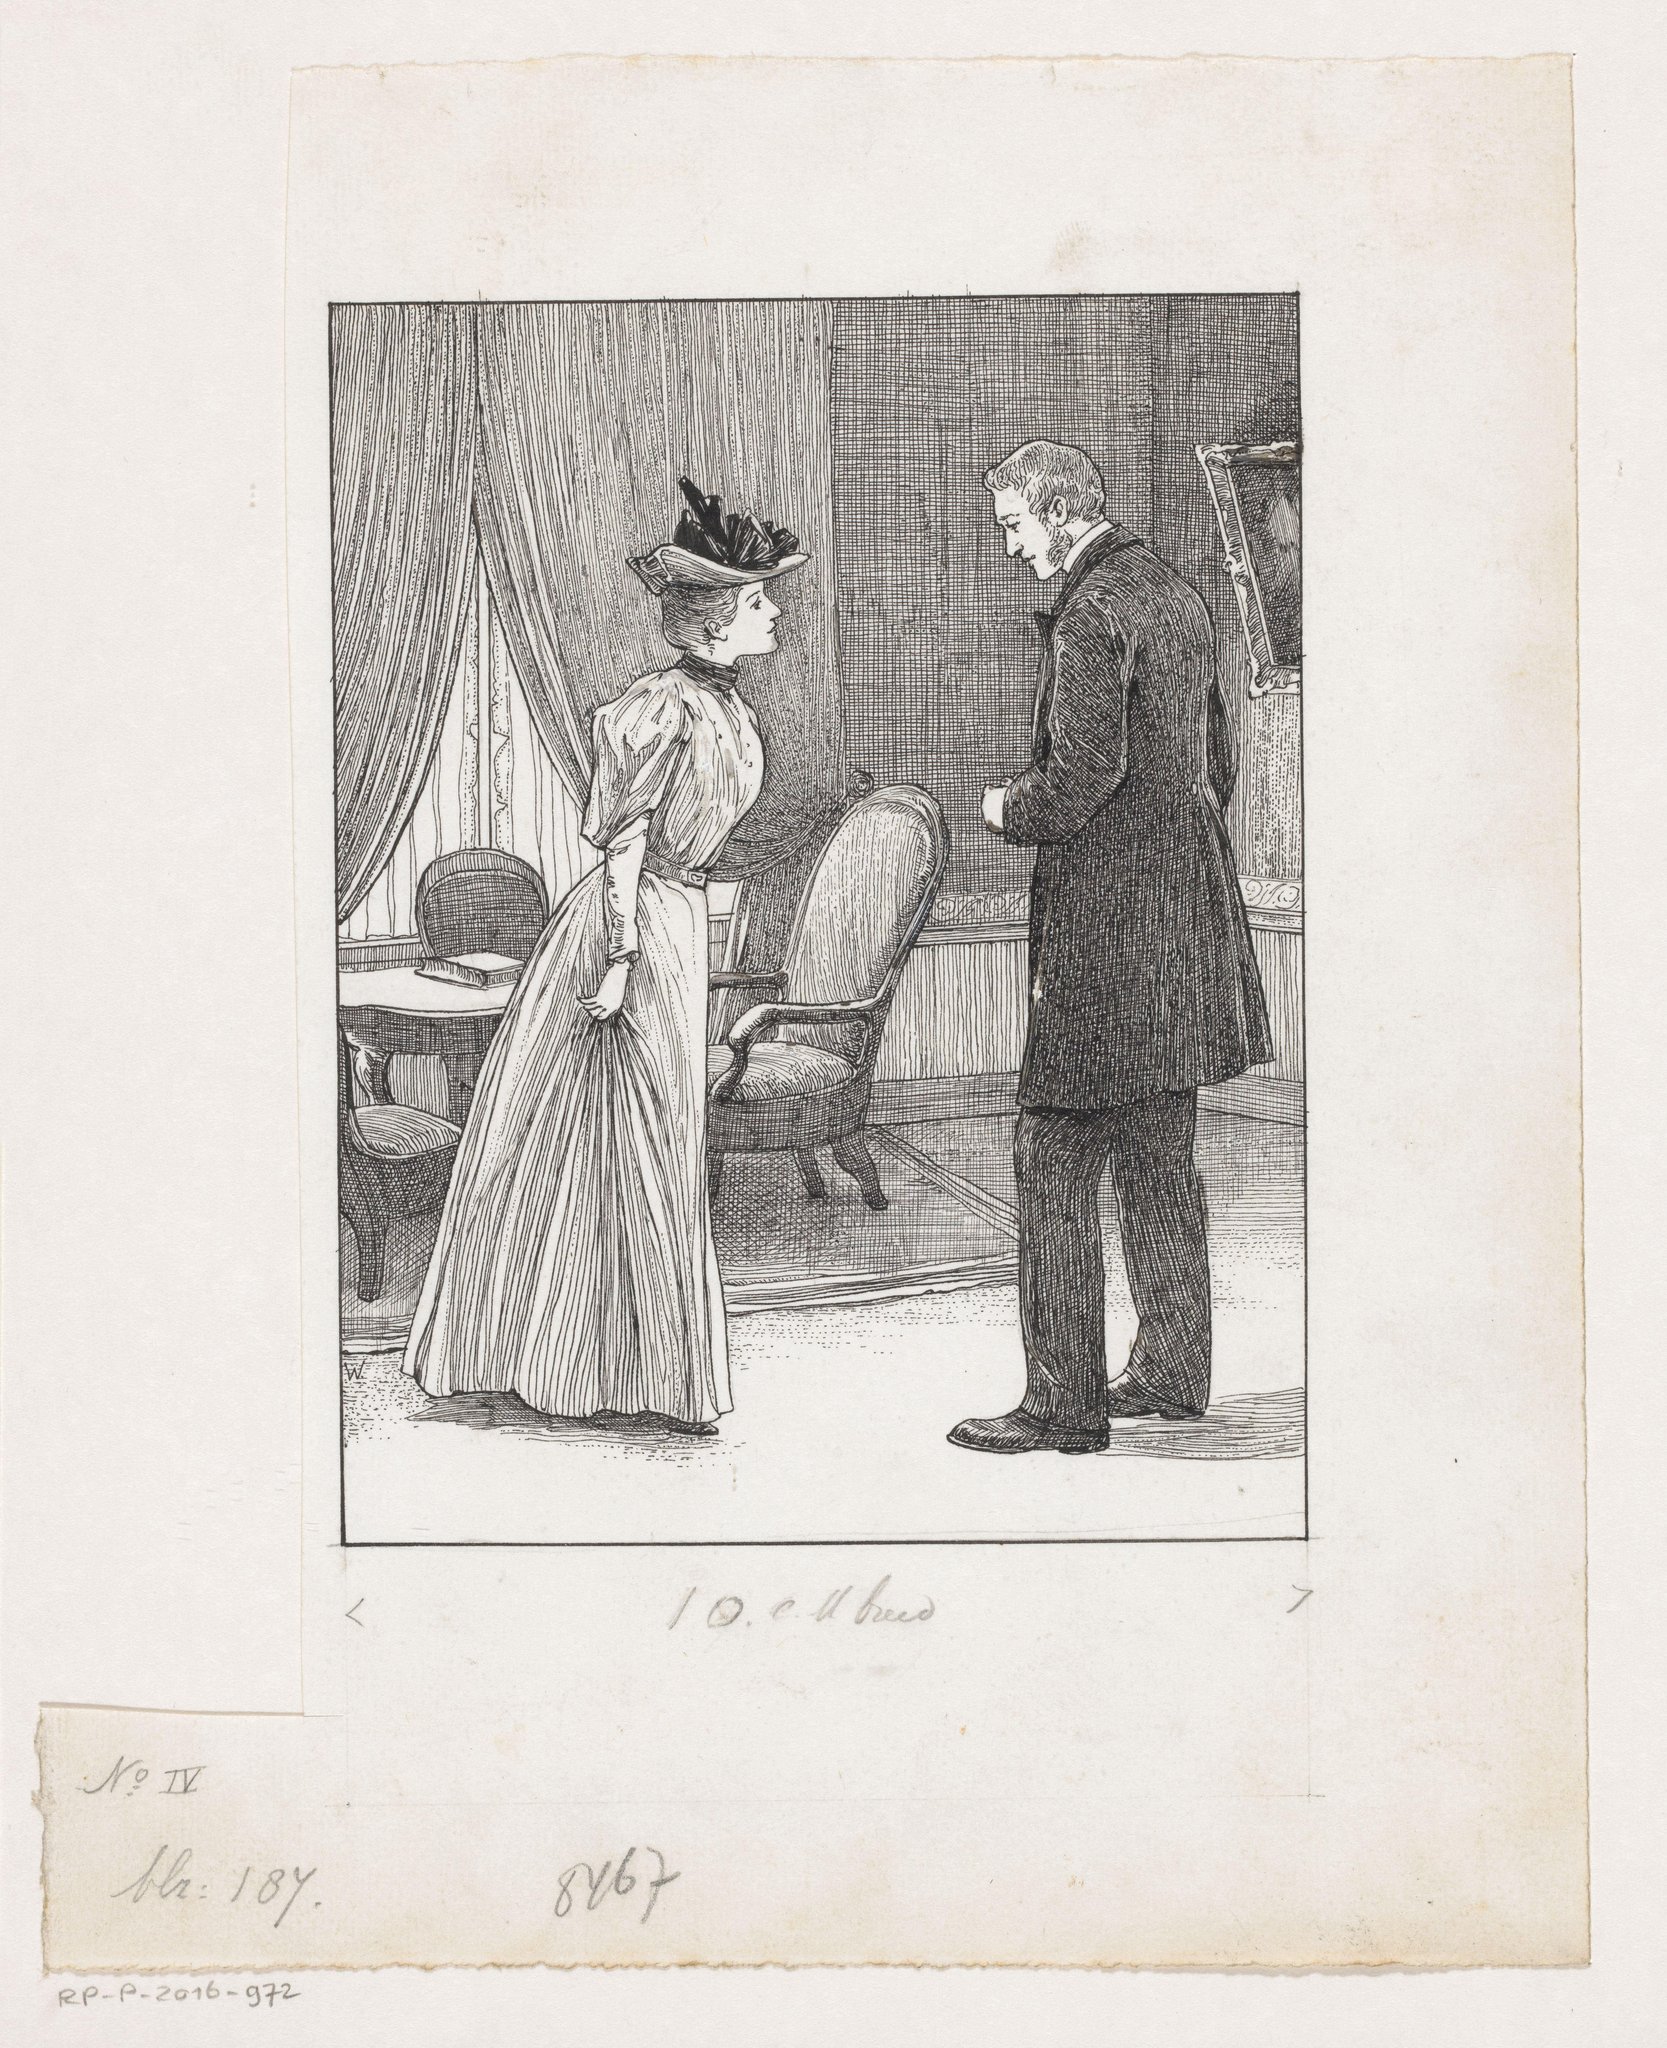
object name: boekillustratie ontwerp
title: Staande man en vrouw in een interieur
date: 1870-1937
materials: paint, ink, paper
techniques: brush, printing block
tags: interior of the house, relations between the sexes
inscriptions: collector's mark: Lugt 2228, annotation: ‘No IV/ blz: 187.’, :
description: Een man en vrouw staan tegenover elkaar in een interieur. Achter hen staan drie stoelen en een tafel waarop een boek ligt.